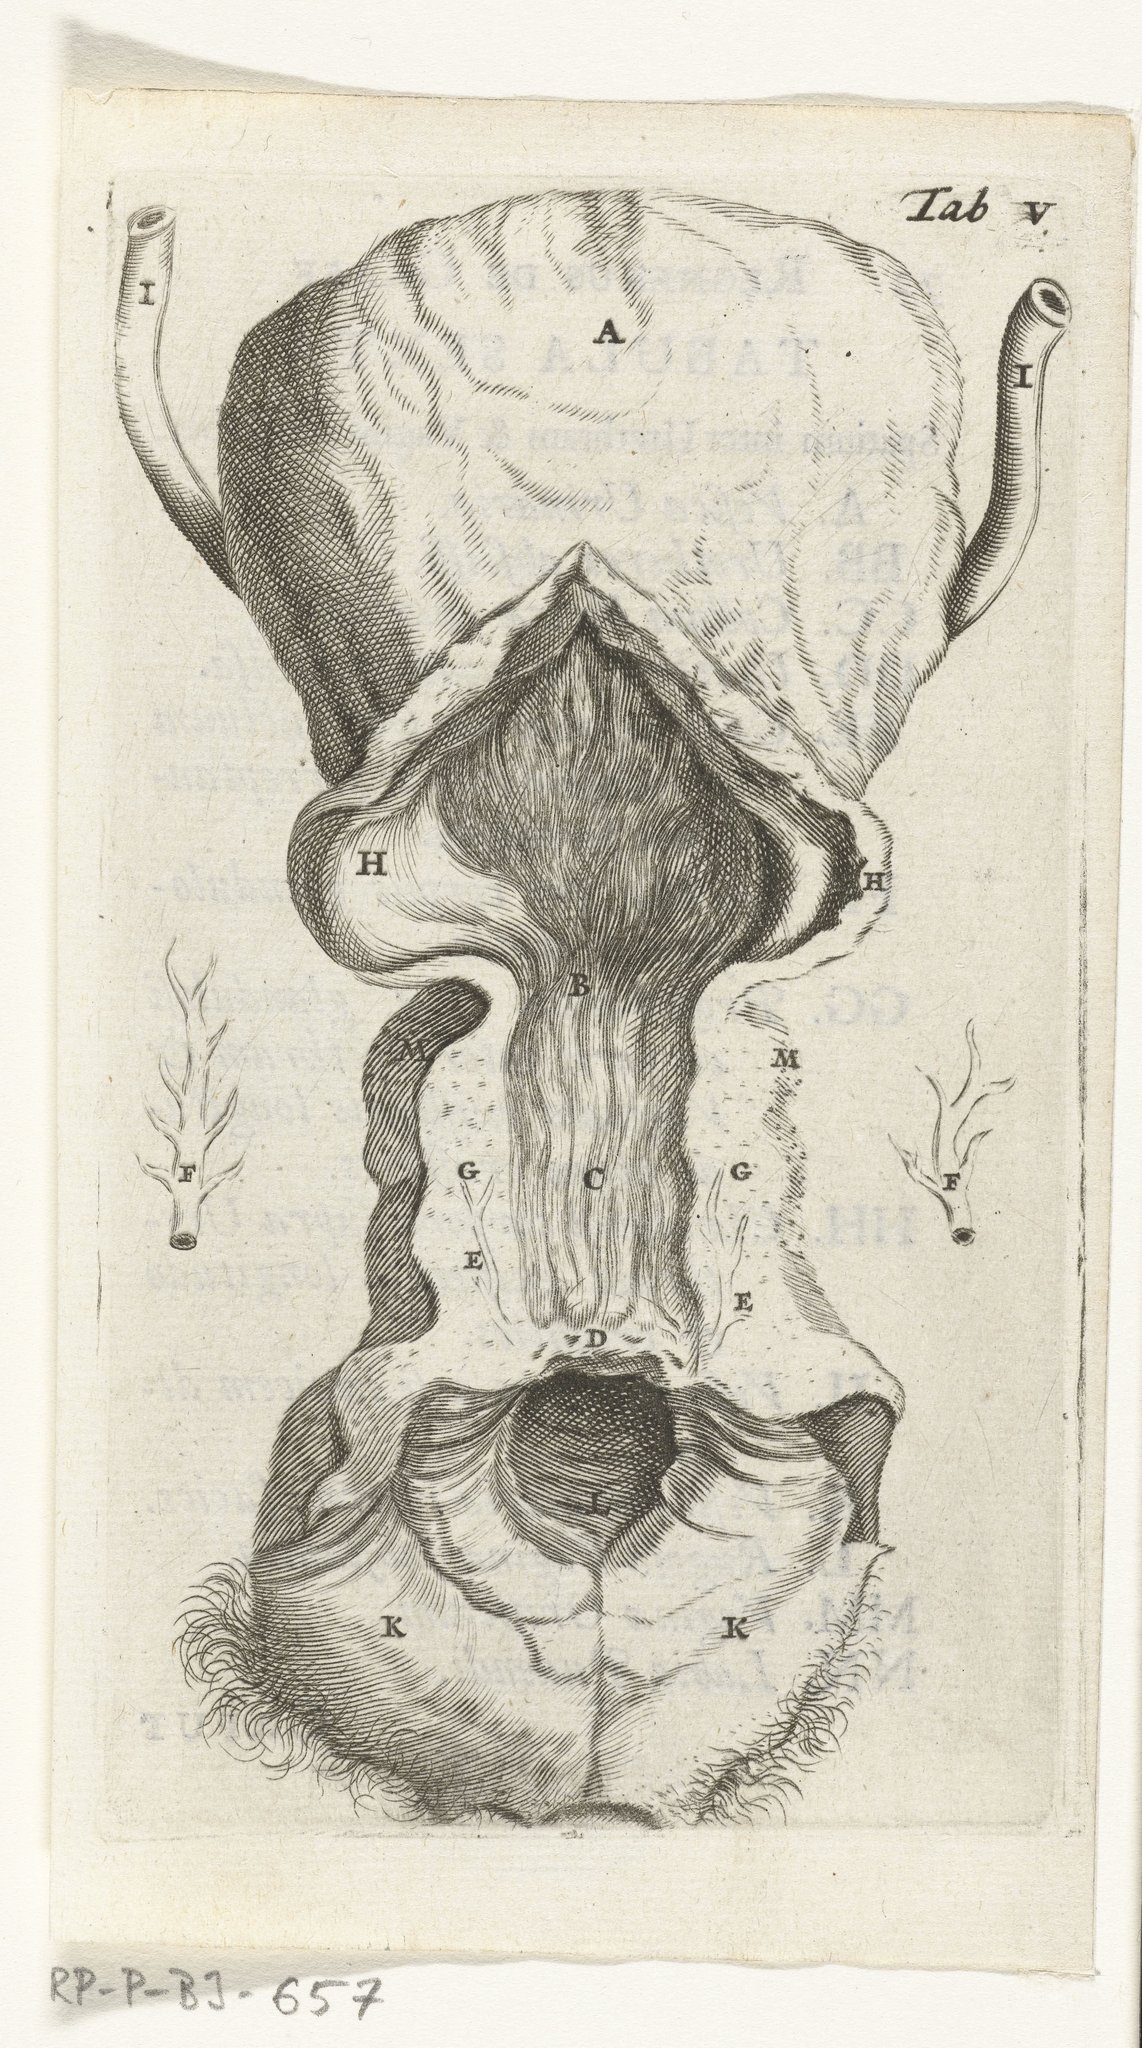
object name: print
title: Prints of the Female Reproductive Organs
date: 1672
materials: paper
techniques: engraving, letterpress printing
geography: netherlands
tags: womb, uterus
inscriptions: collector's mark: Lugt 2228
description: In 1672, physician and anatomist Reinier de Graaf published his De mulierum organis about the female reproductive organs. The book contains detailed prints by Hendrik Bary, among them several of the vagina. De Graaf was the first to conclude that a foetus was the product not just of a man’s seed, but also of a woman’s egg. He discovered what he called blisters, which later became known as Graafian follicles.